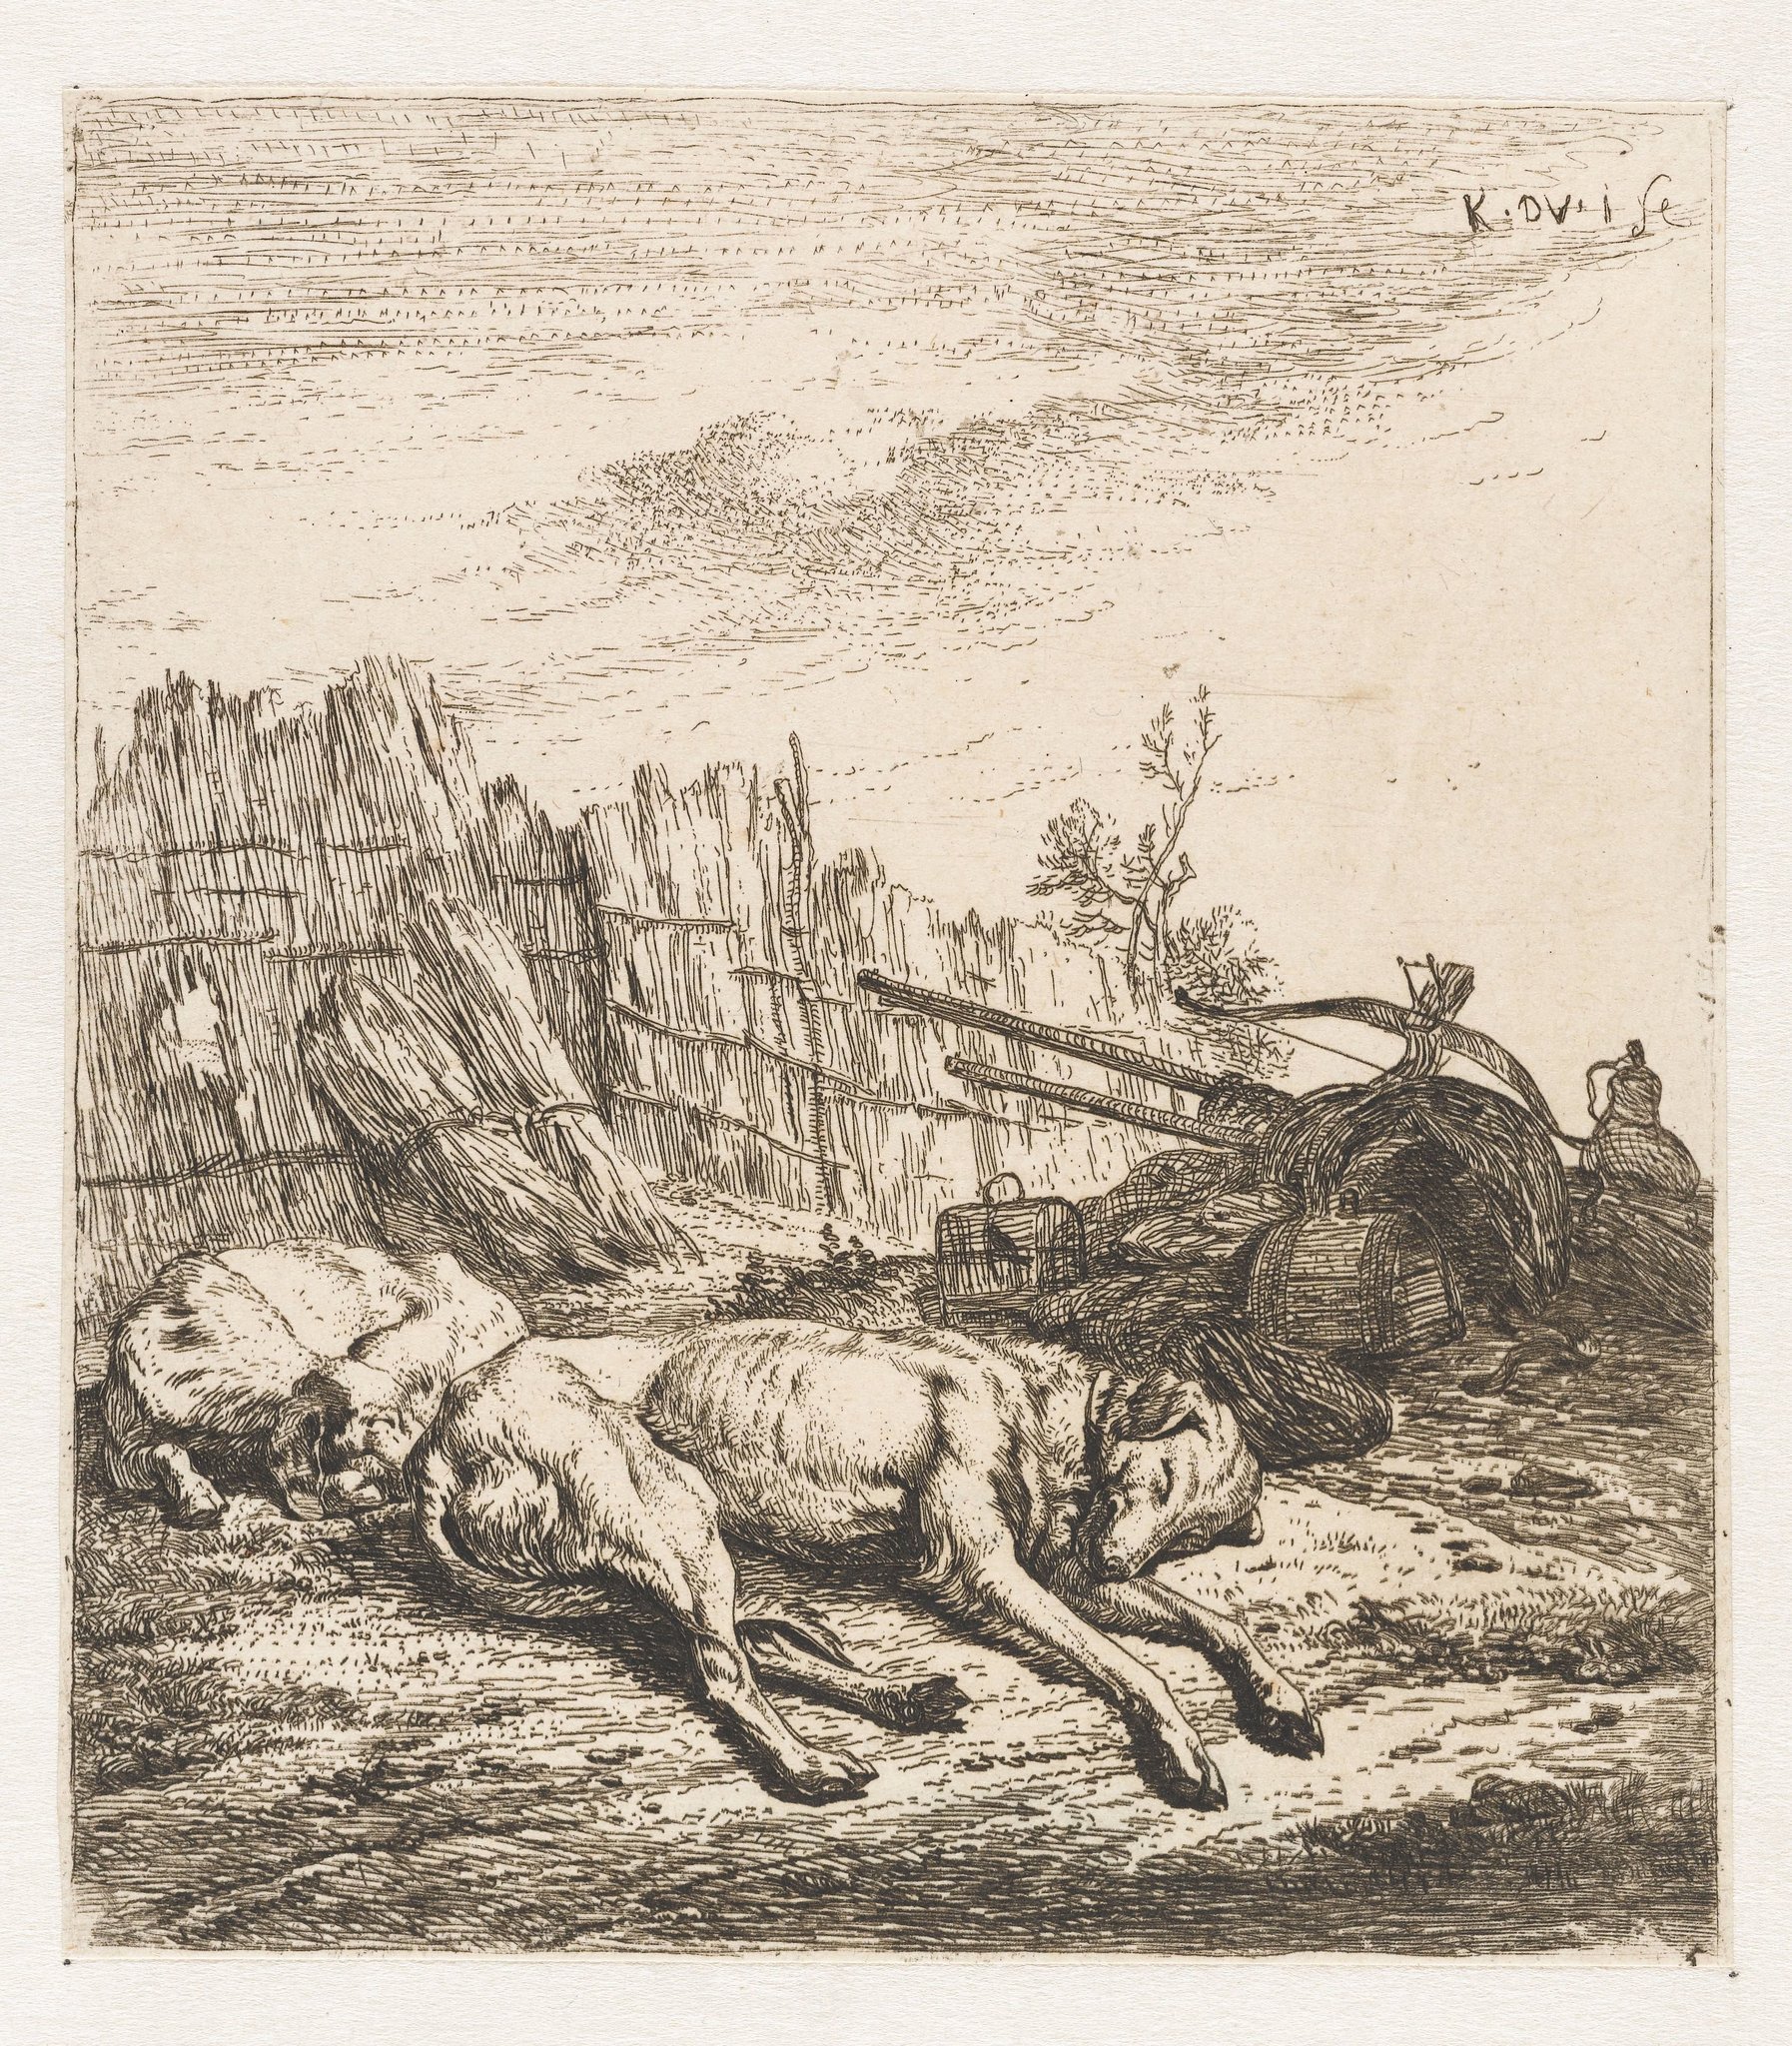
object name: print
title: Slapende jachthonden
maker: karel du jardin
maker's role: draughtsman, painter, print maker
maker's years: 1626-1678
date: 1652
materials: paper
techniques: etching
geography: amsterdam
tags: hunting dogs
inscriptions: collector's mark: Lugt 2228a